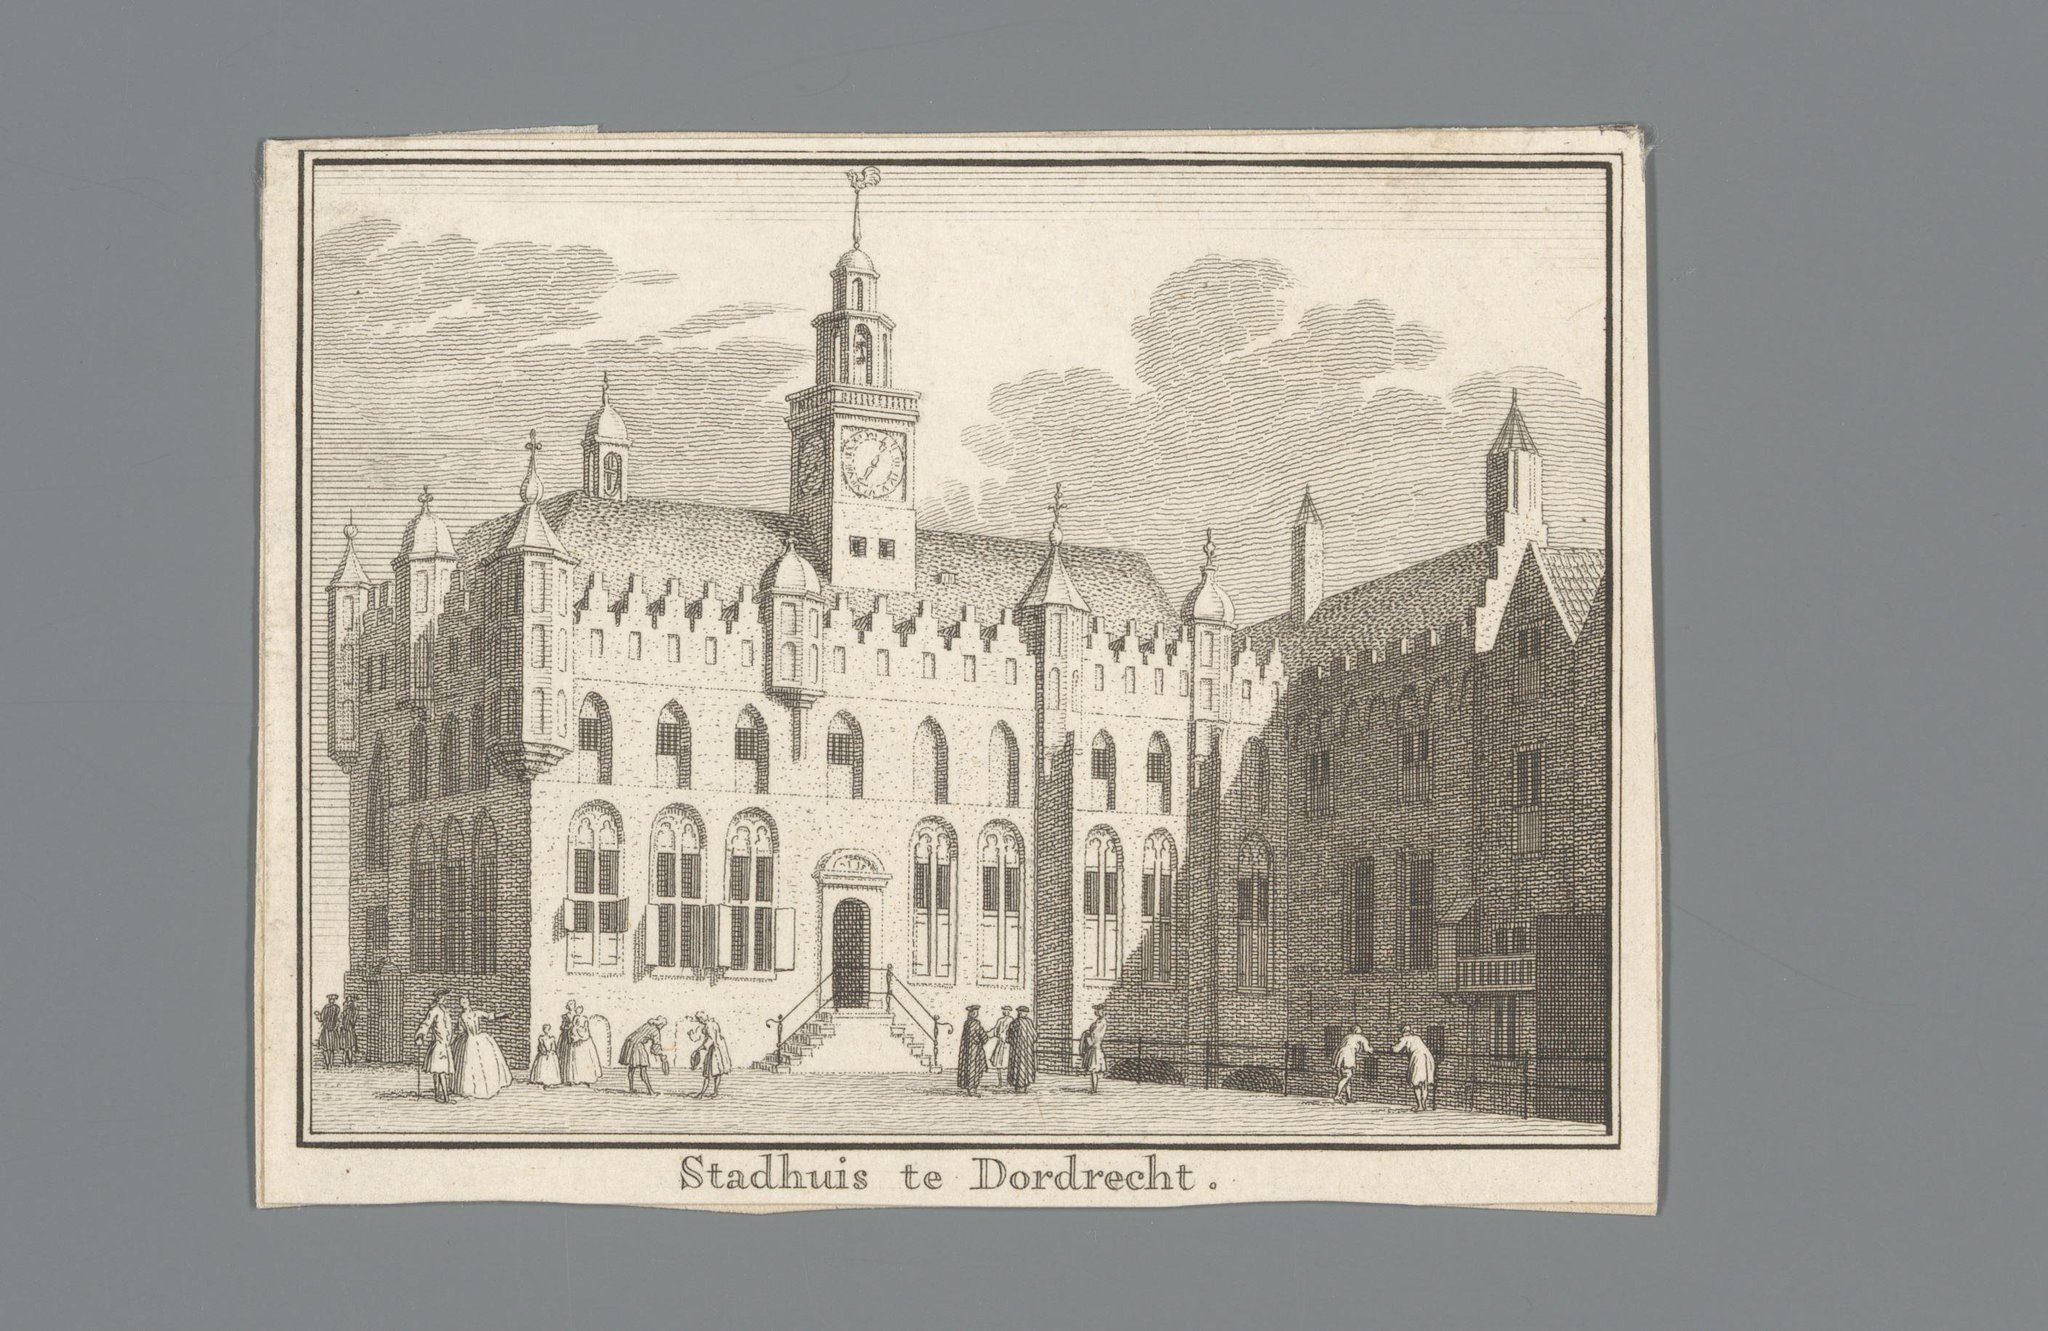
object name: print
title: Gezicht op het stadhuis van Dordrecht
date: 1742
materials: paper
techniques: etching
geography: amsterdam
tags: townhall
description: Prent uit: Wagenaar, Jan. Tegenwoordige Staat der Vereenigde Nederlanden (...). Amsterdam: Isaak Tirion, 1742, dl. 4, tussen p. 304 en 305.